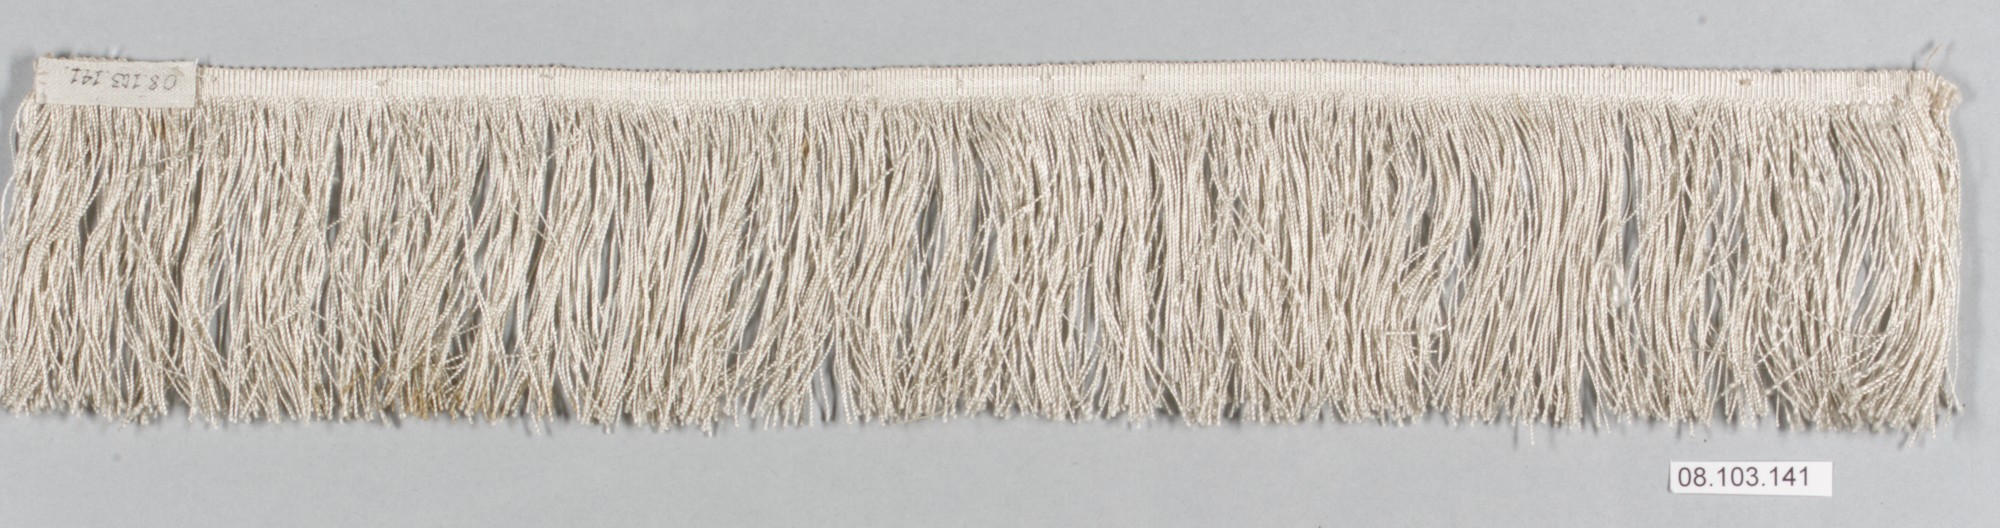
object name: fringe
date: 1880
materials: silk